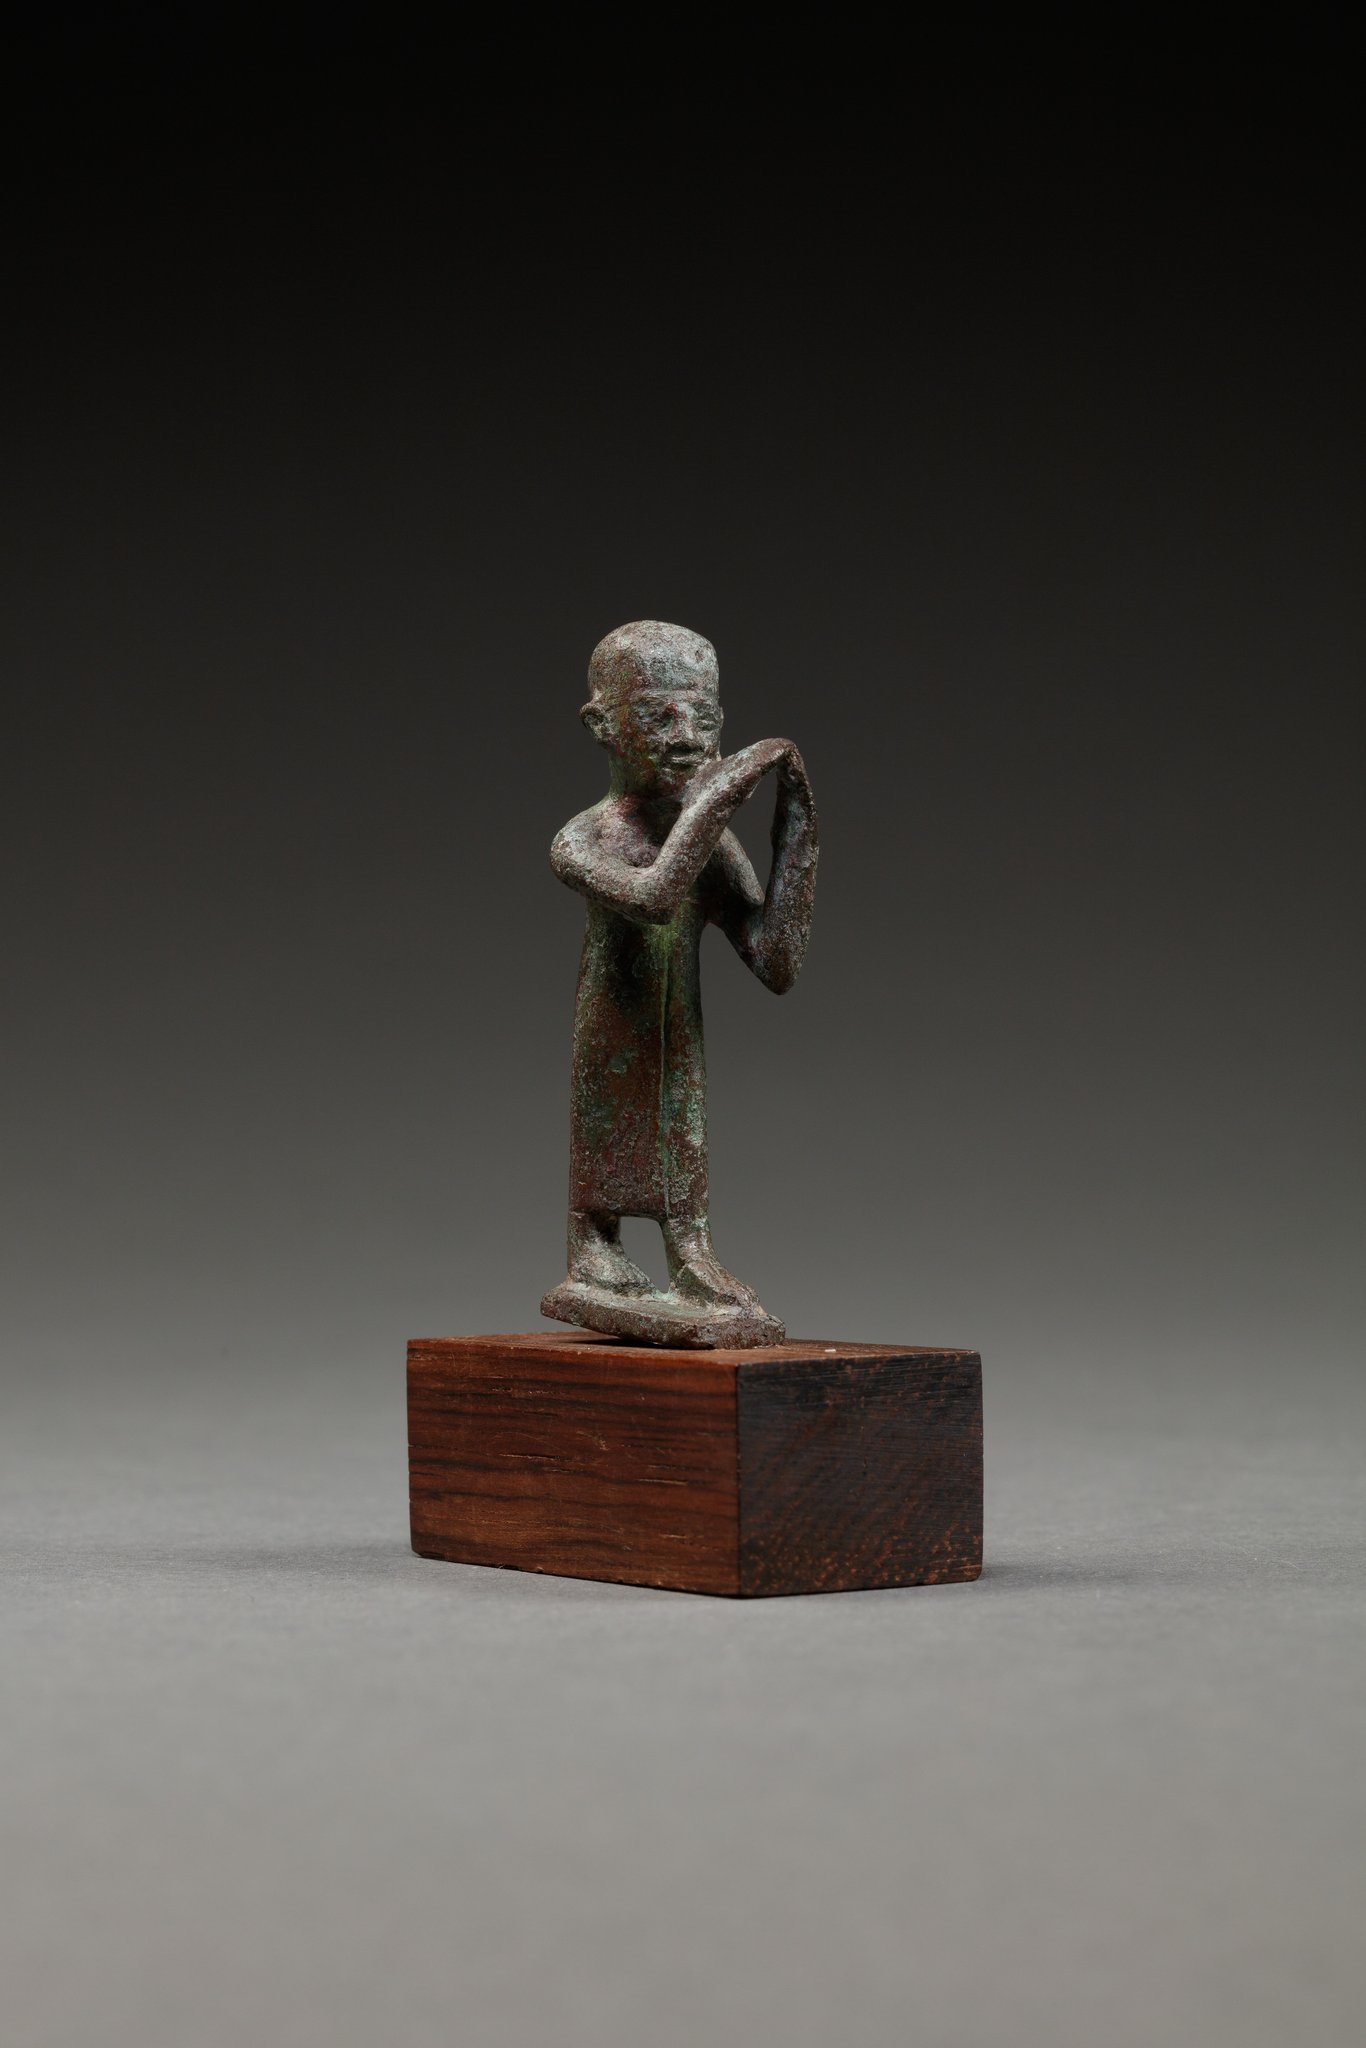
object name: bronze, non royal, private, flutist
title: Statuette of a flutist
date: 301-400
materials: copper alloy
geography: egypt